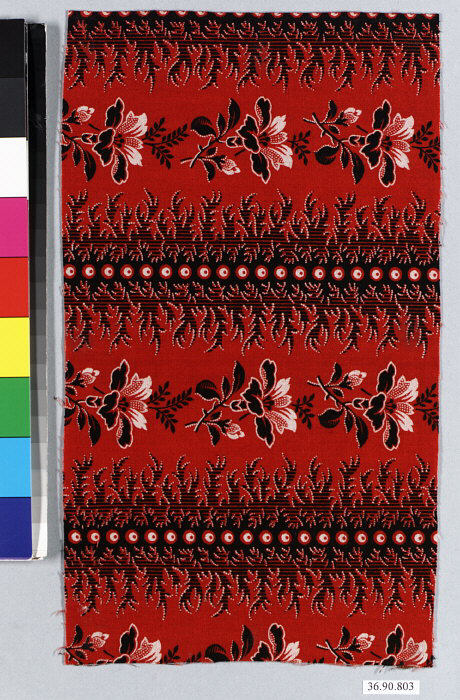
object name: piece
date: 1867-1900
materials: cotton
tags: flowers,leaves